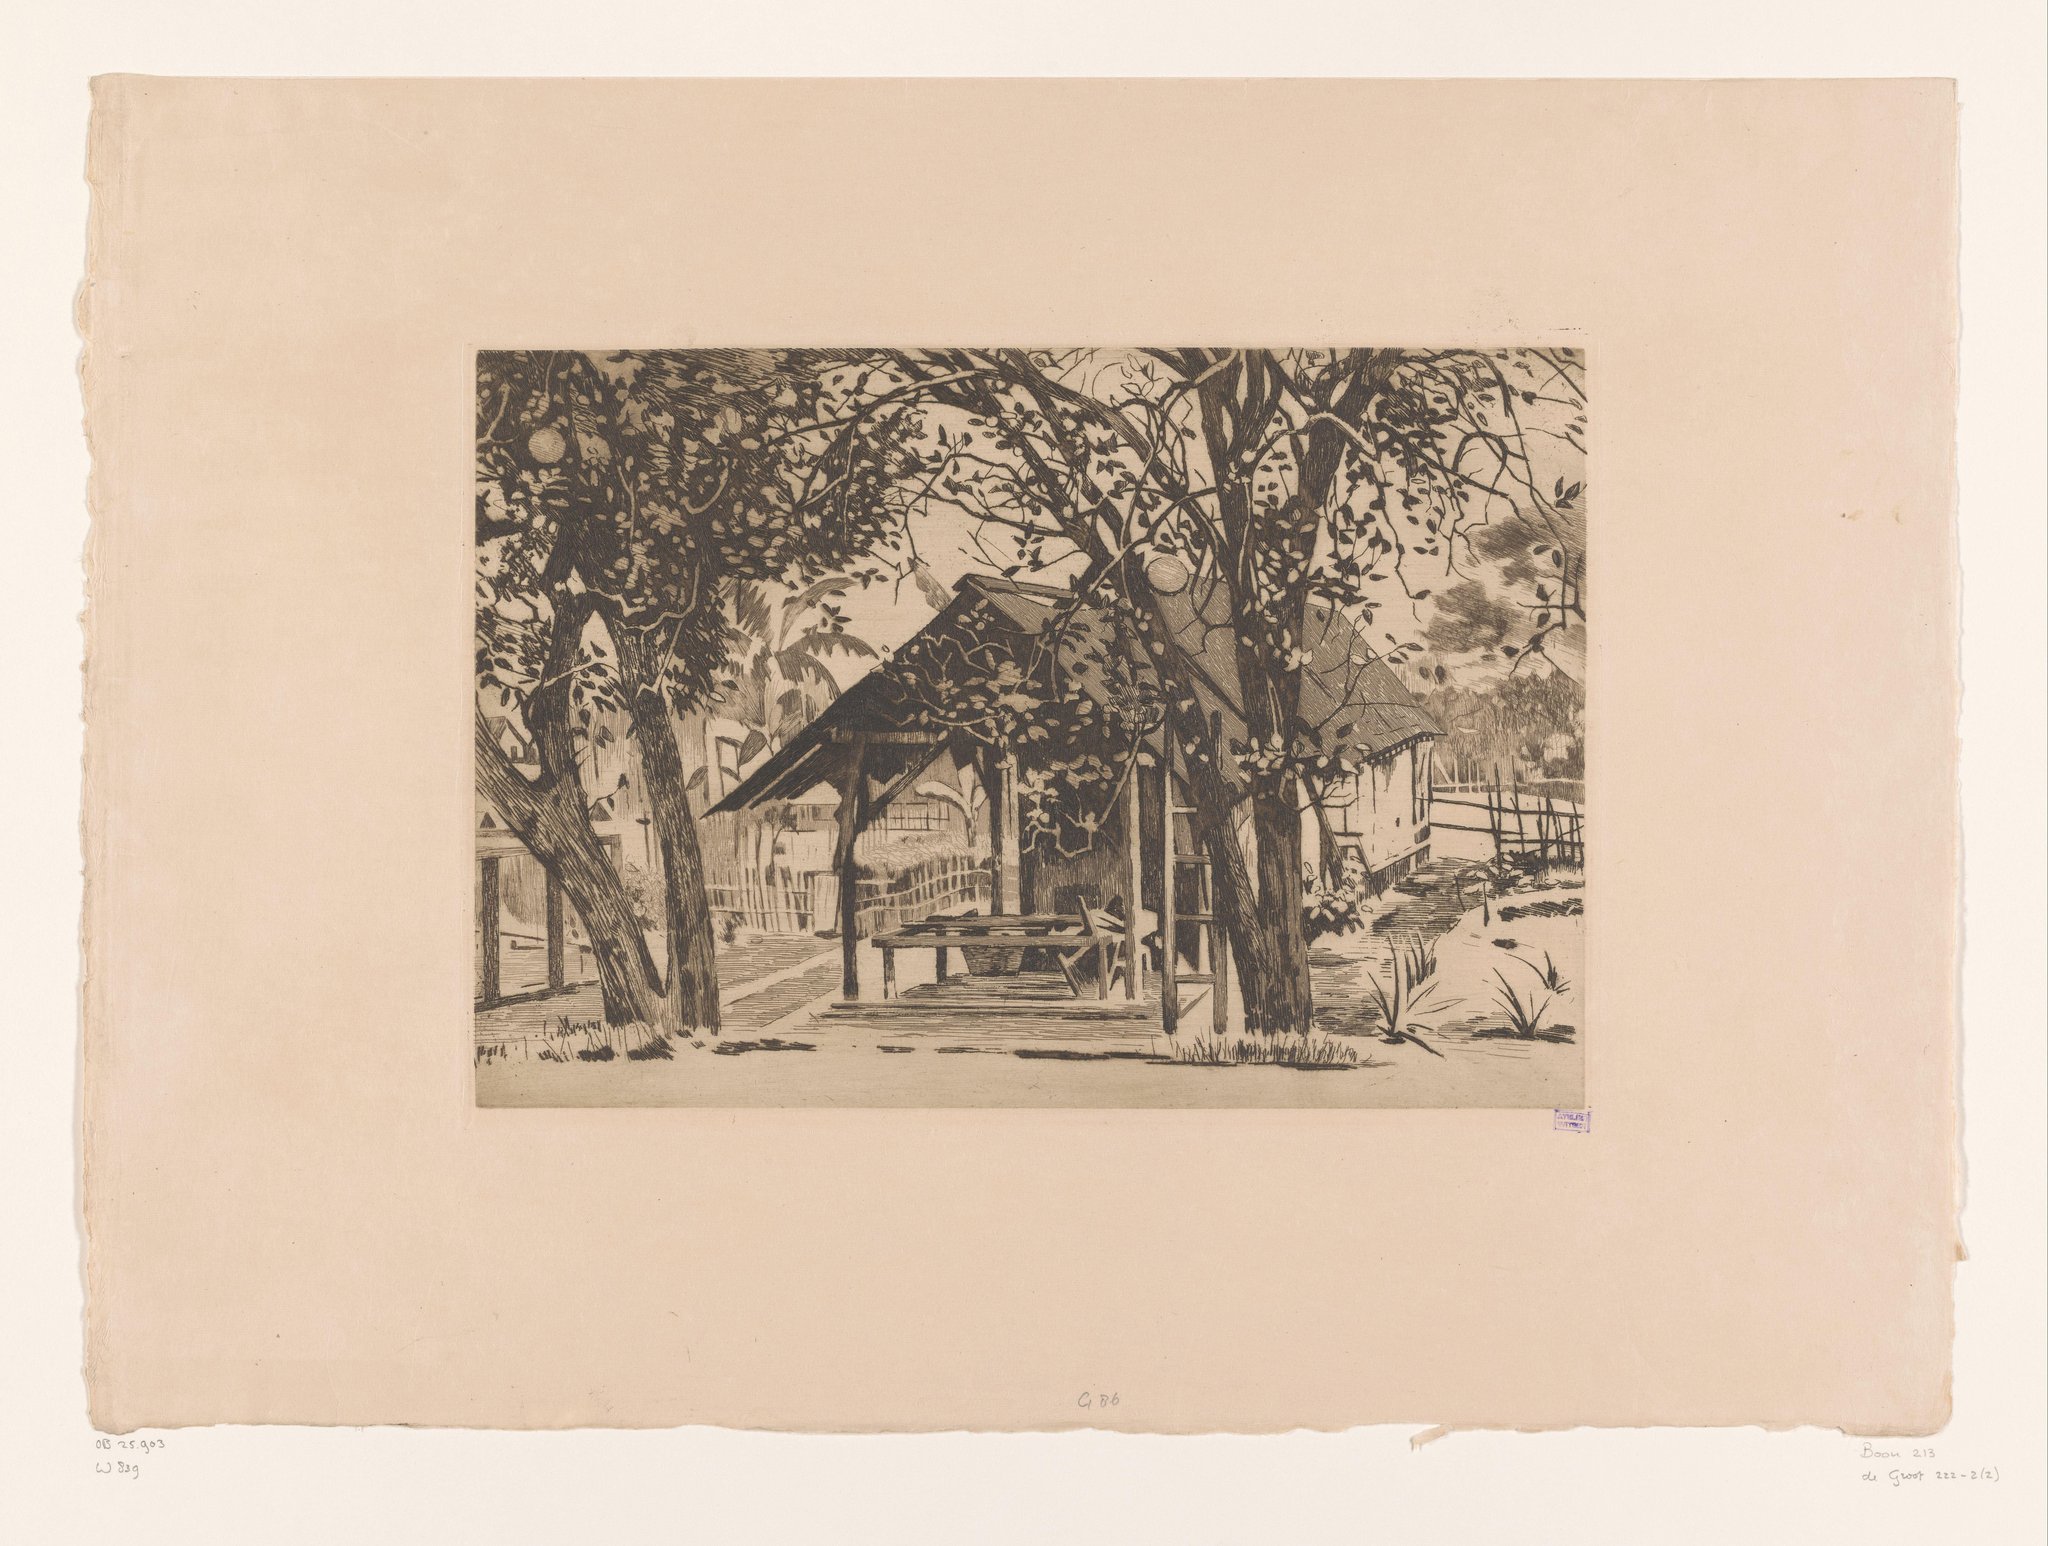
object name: print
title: Bijgebouw op de plantage Gambar te Java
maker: willem witsen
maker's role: draughtsman, painter, print maker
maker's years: 1860-1923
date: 1921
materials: paper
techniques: etching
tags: plantation, barn, landscapes in tropical and sub-tropical regions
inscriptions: workshop stamp: ‘Atelier Witsen’